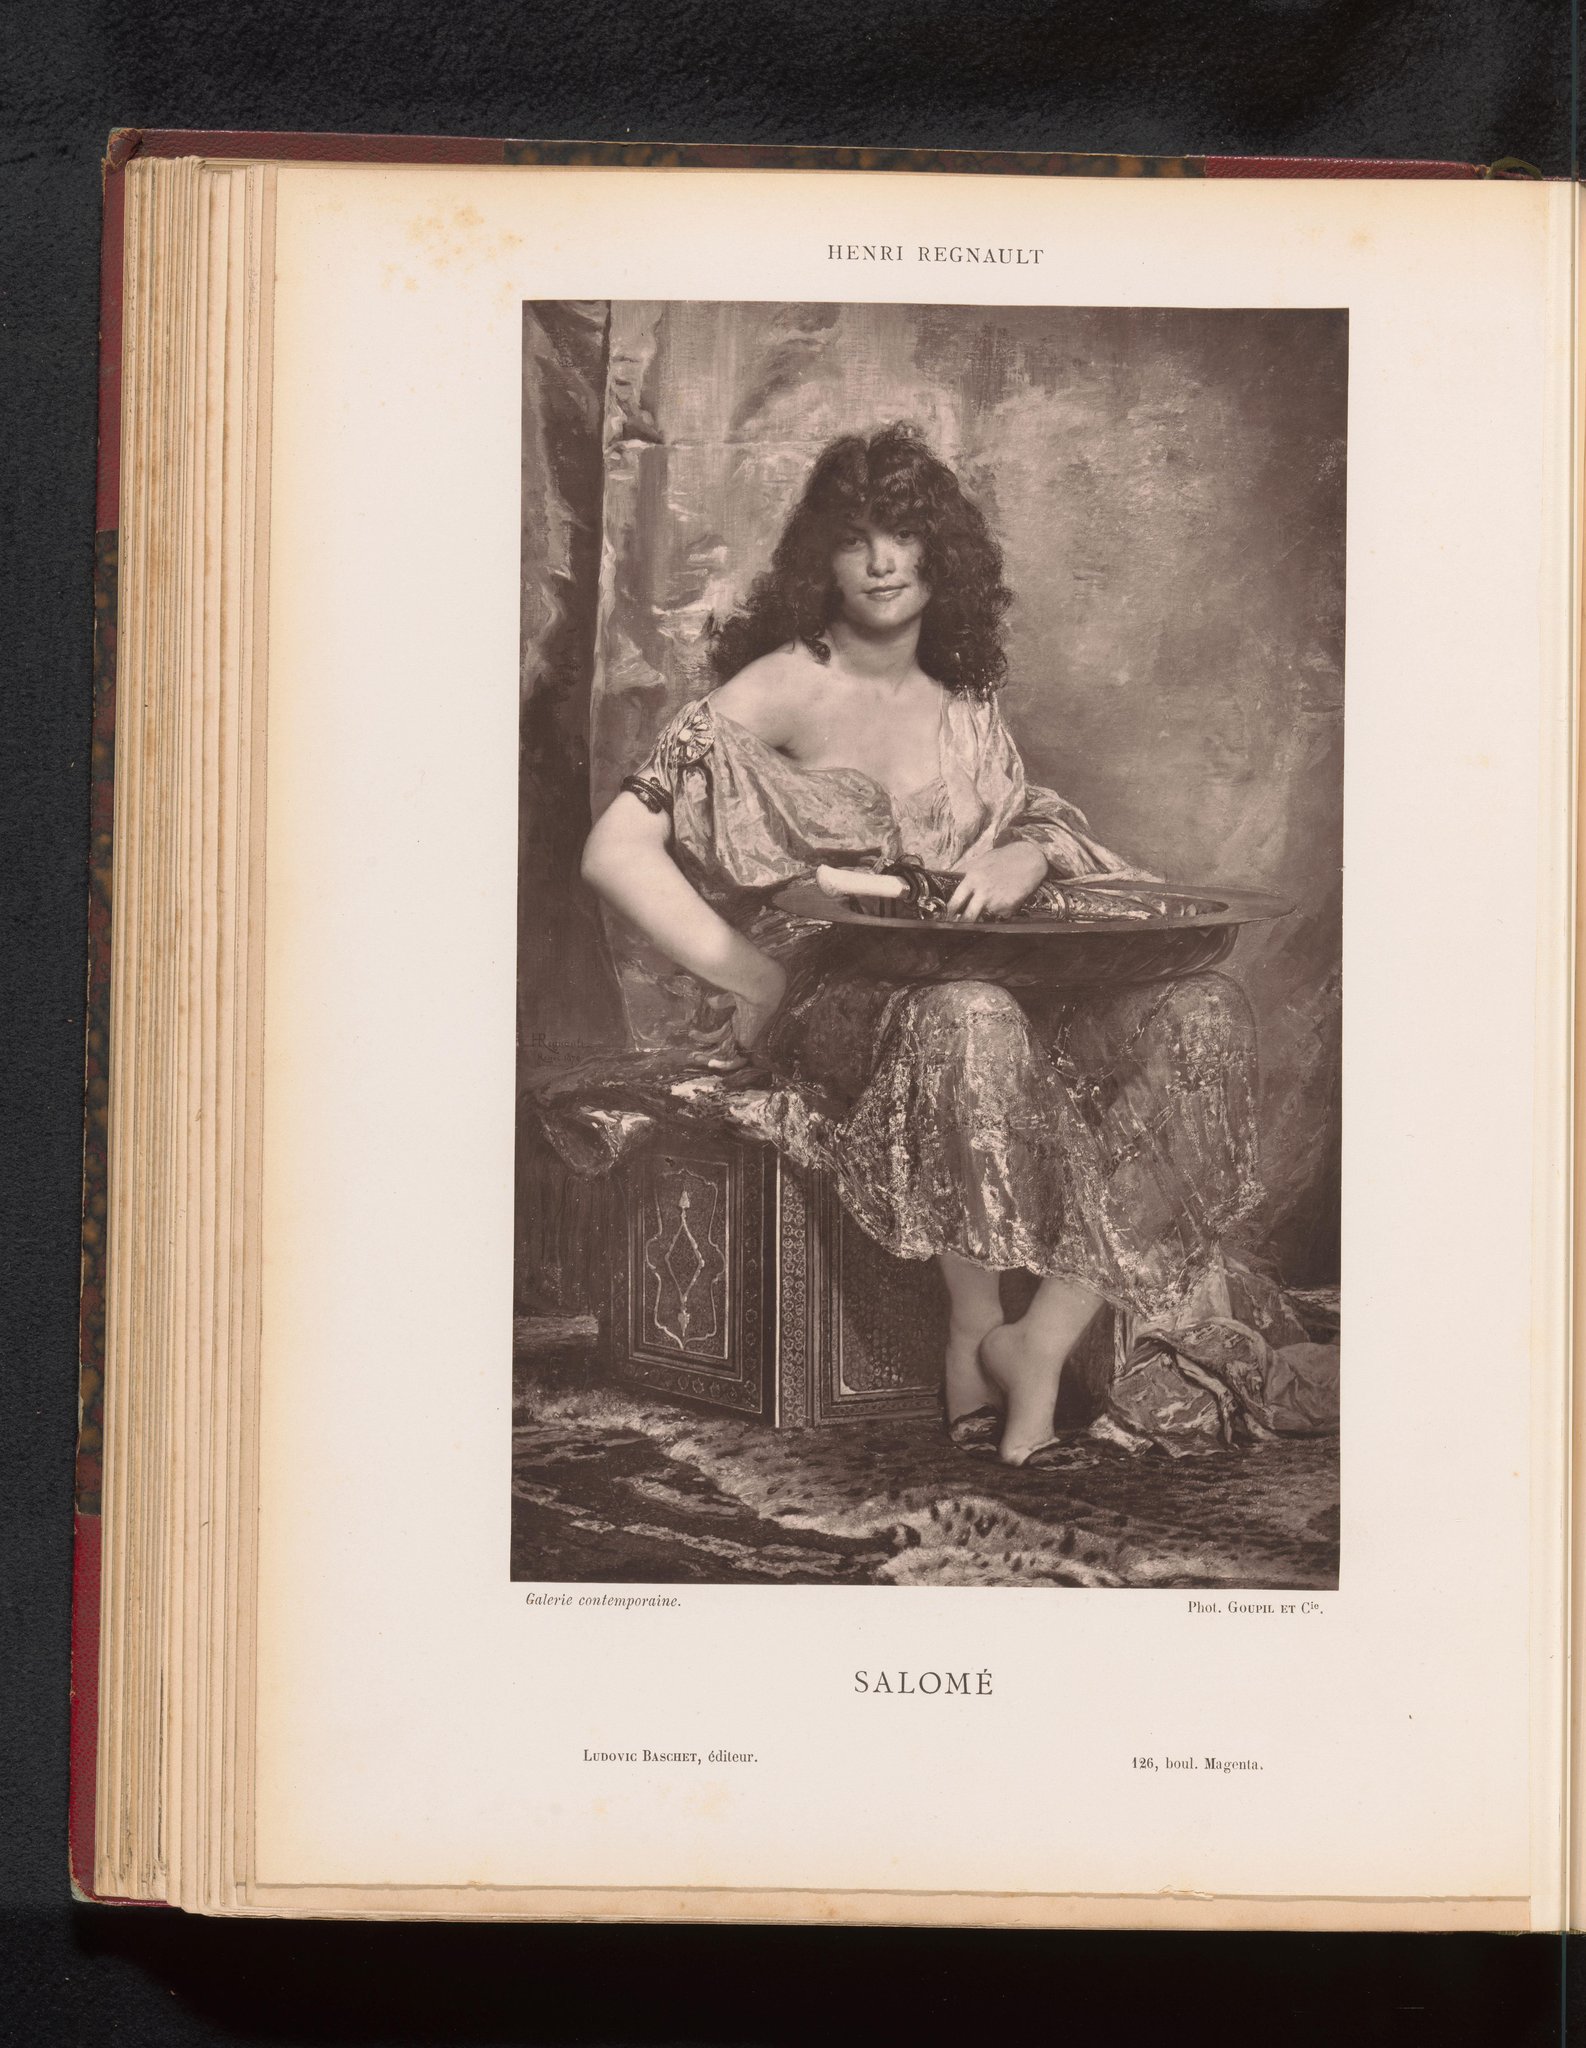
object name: photomechanical print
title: Reproductie van Salomé door Henri Regnault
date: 1871-1876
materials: paper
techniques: woodburytype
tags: adult woman, female persons from the new testament (not in biblical context), painting, drawing and the graphic arts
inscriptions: inscription: ‘Galerie Contemporaine/ Ludovic Baschet, éditeur.’